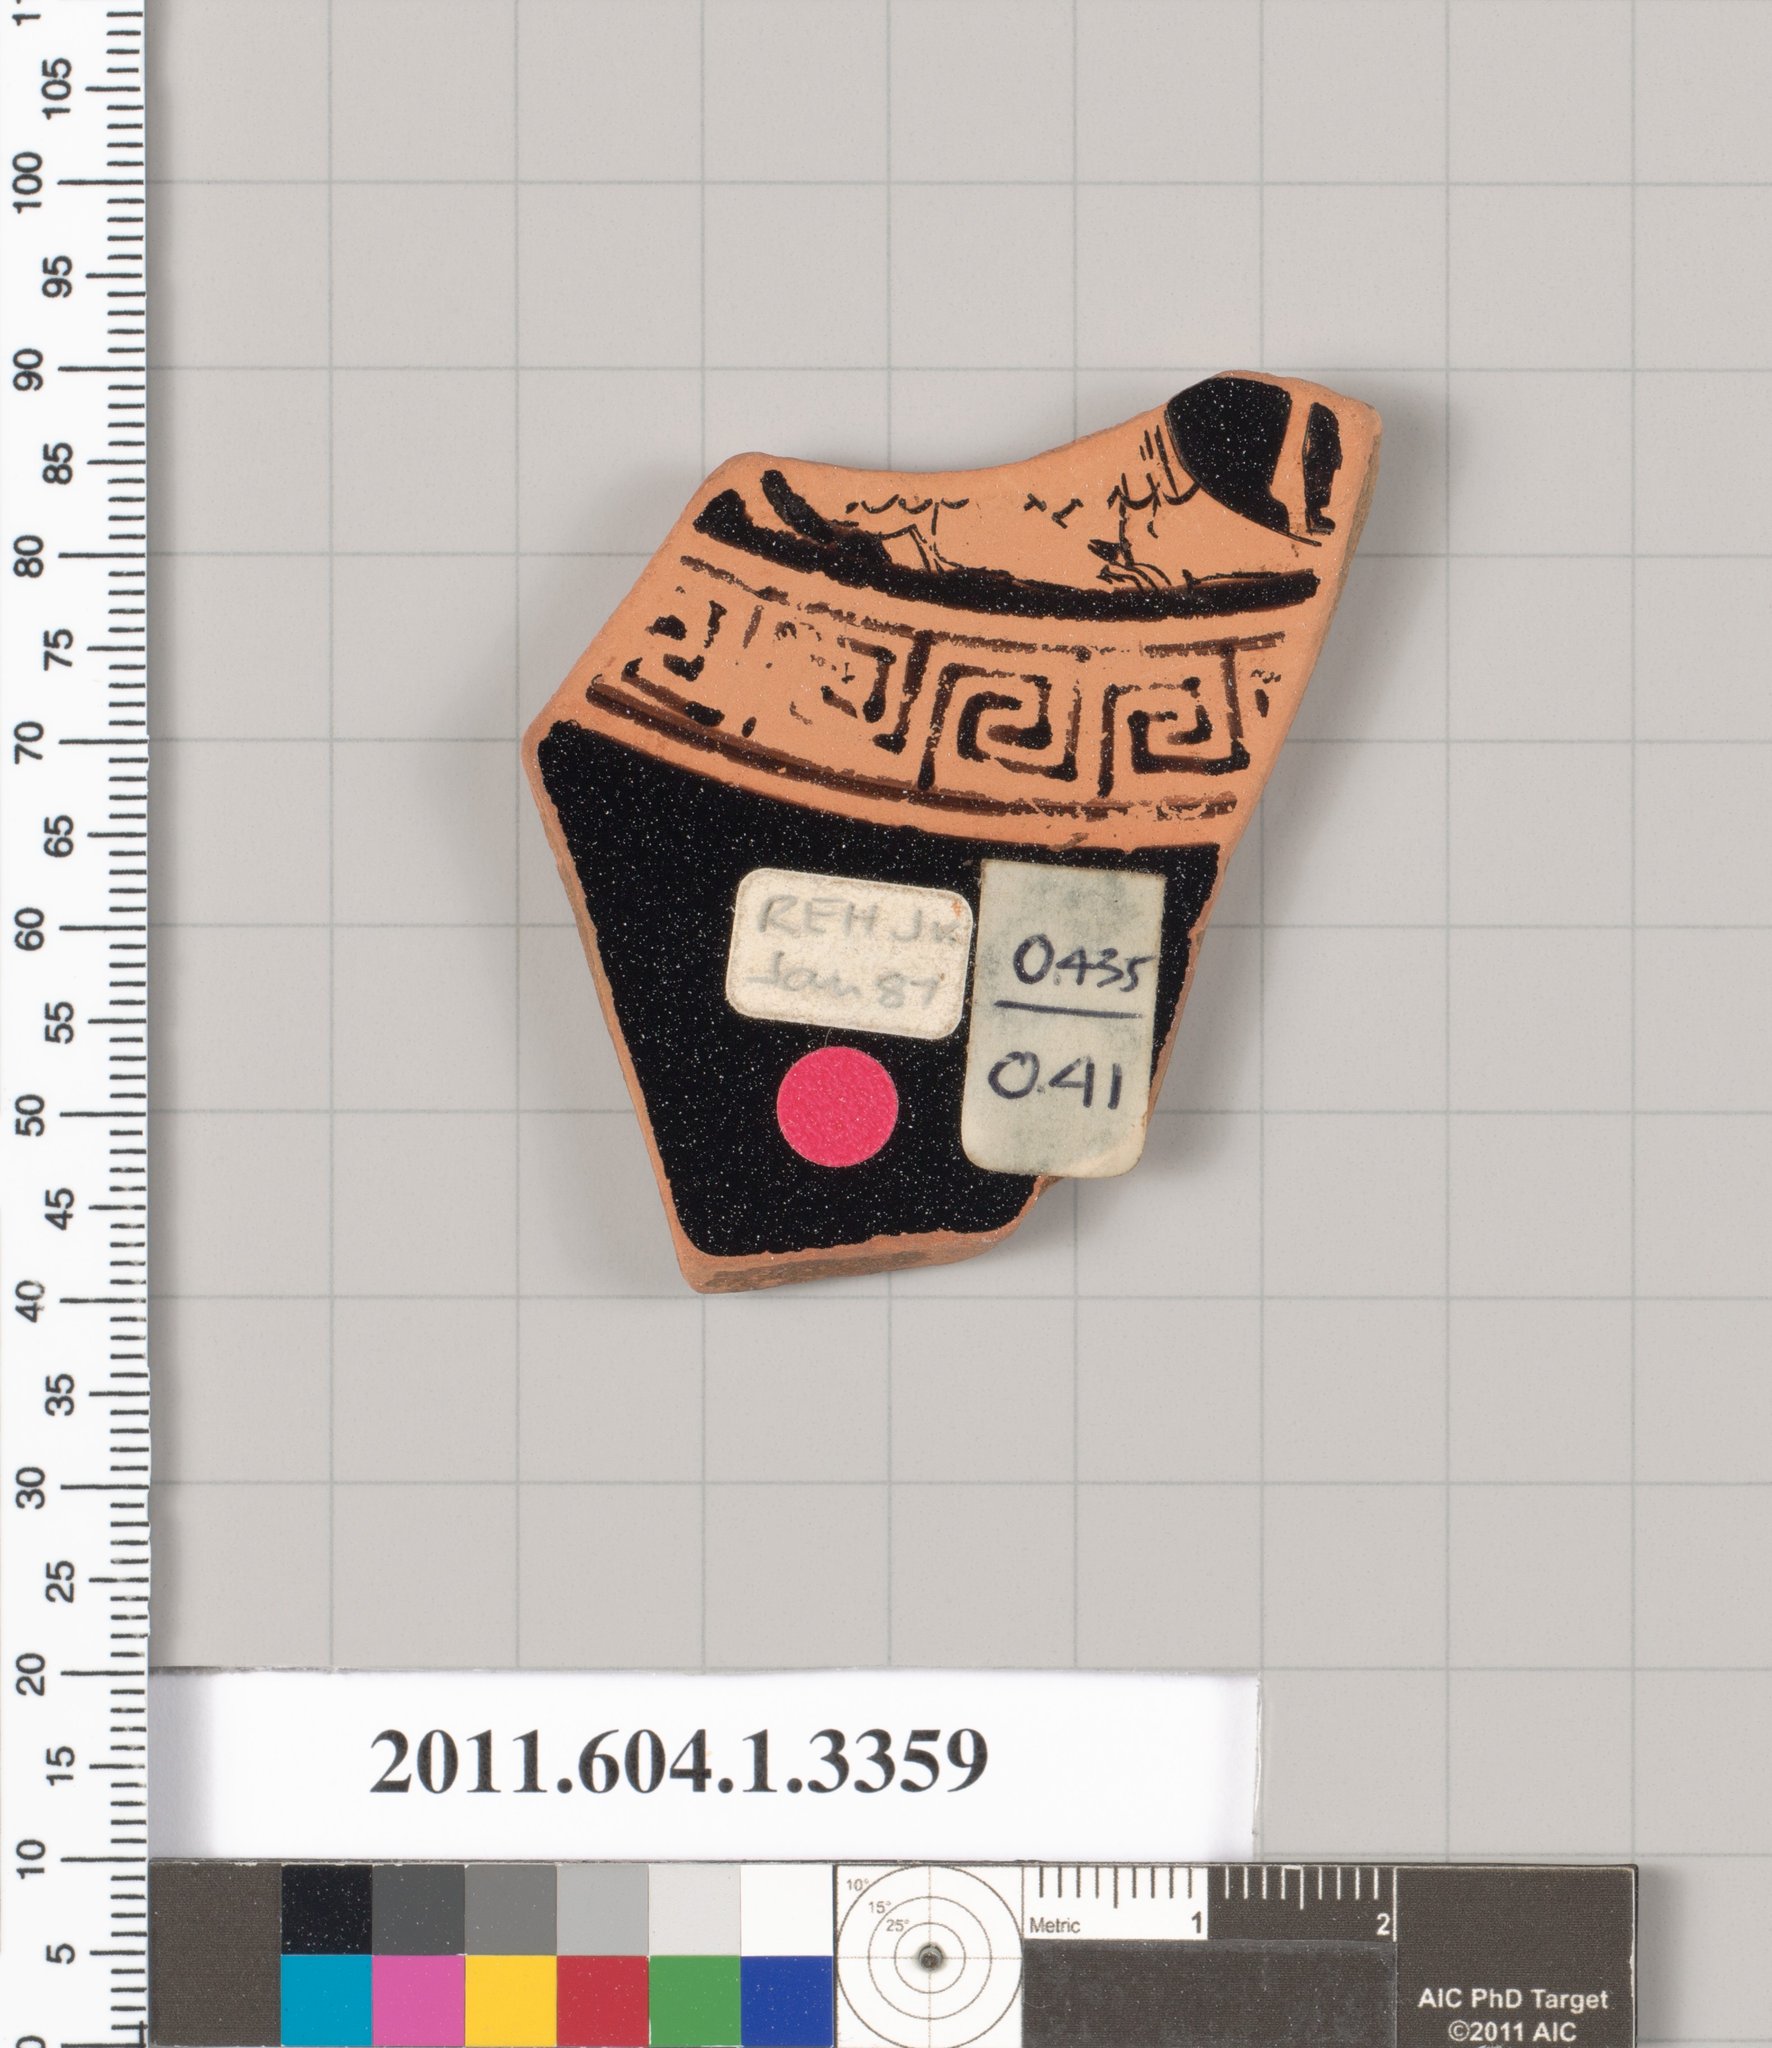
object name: kylix fragment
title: Terracotta fragment of a kylix (drinking cup)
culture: greek, attic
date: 490-480 BCE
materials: terracotta